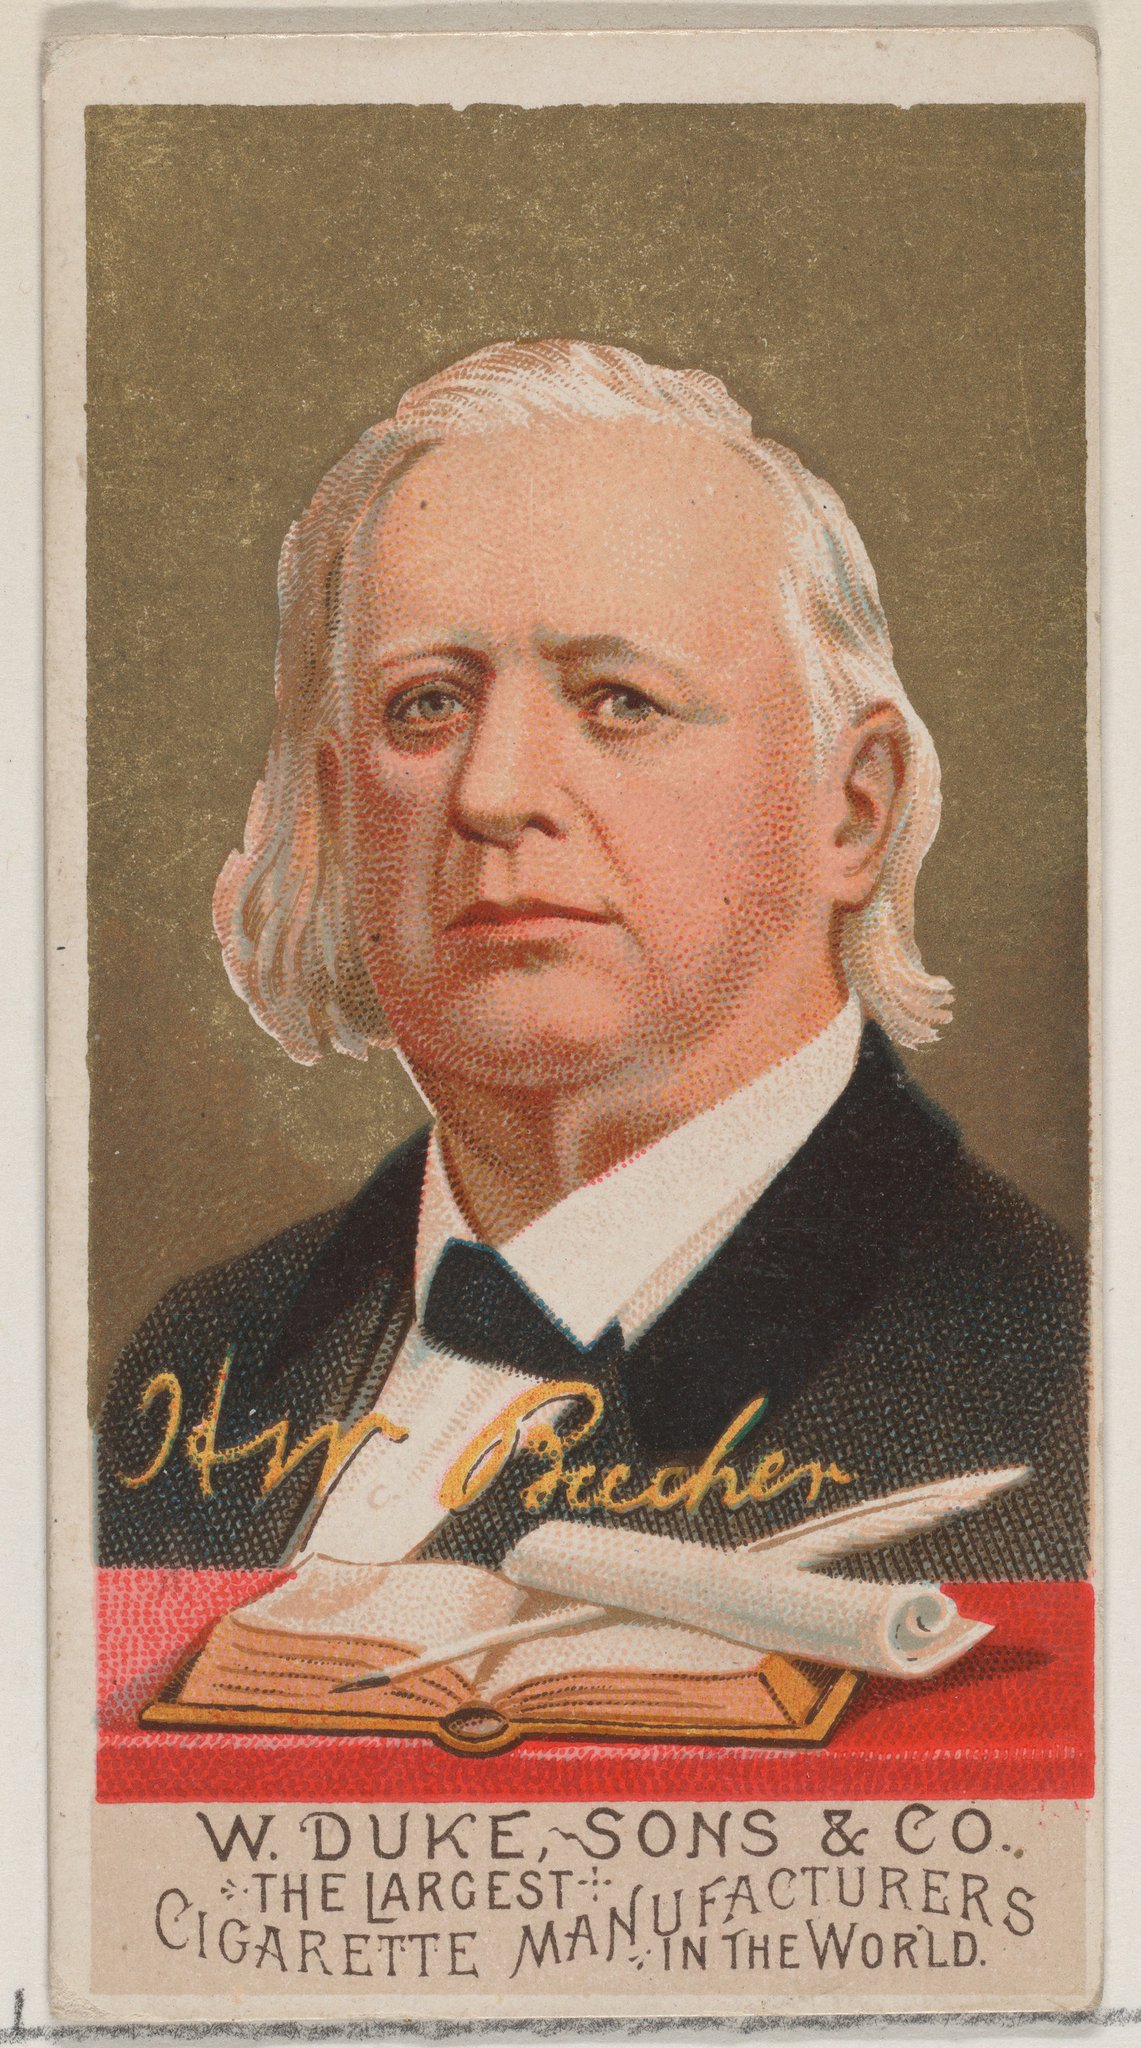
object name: print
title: H.W. Beecher, from the series Great Americans (N76) for Duke brand cigarettes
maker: w. duke, sons & co.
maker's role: publisher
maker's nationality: american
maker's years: 1870-1920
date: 1888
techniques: color lithograph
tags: men